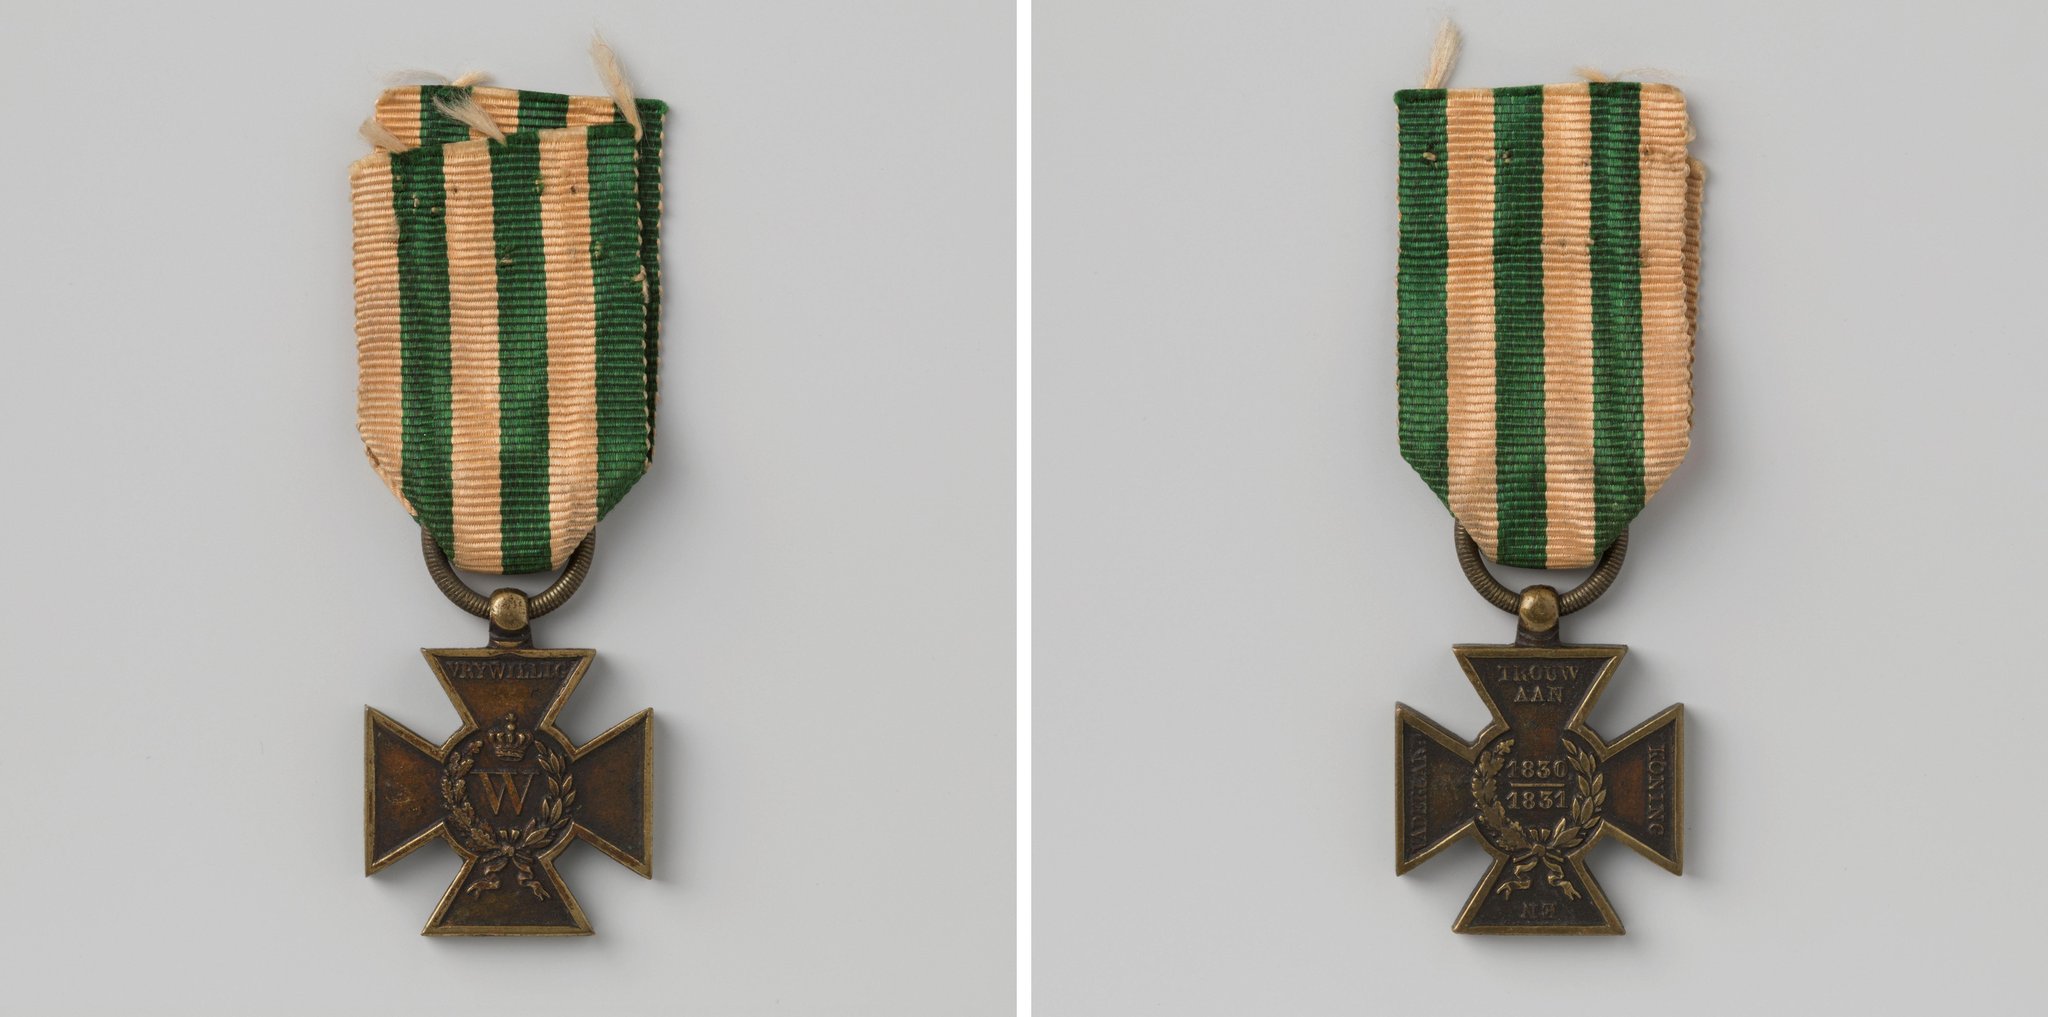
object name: draagpenning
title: Metalen Kruis voor vrijwilligers, miniatuur 17 mm, 1831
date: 1831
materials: bronze, textile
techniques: striking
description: Bronzen kruis met bal en draagring aan een groen-geel gestreept lint, op de voorzijde een gekroonde letter W tussen samengestrikte eiken- en lauwertakken, op het bovenste been VRYWILLIG, op de keerzijde 1830-1831 tussen samengestrikte eiken- en lauwertakken, op de benen TROUW AAN - KONING - EN - VADERLAND